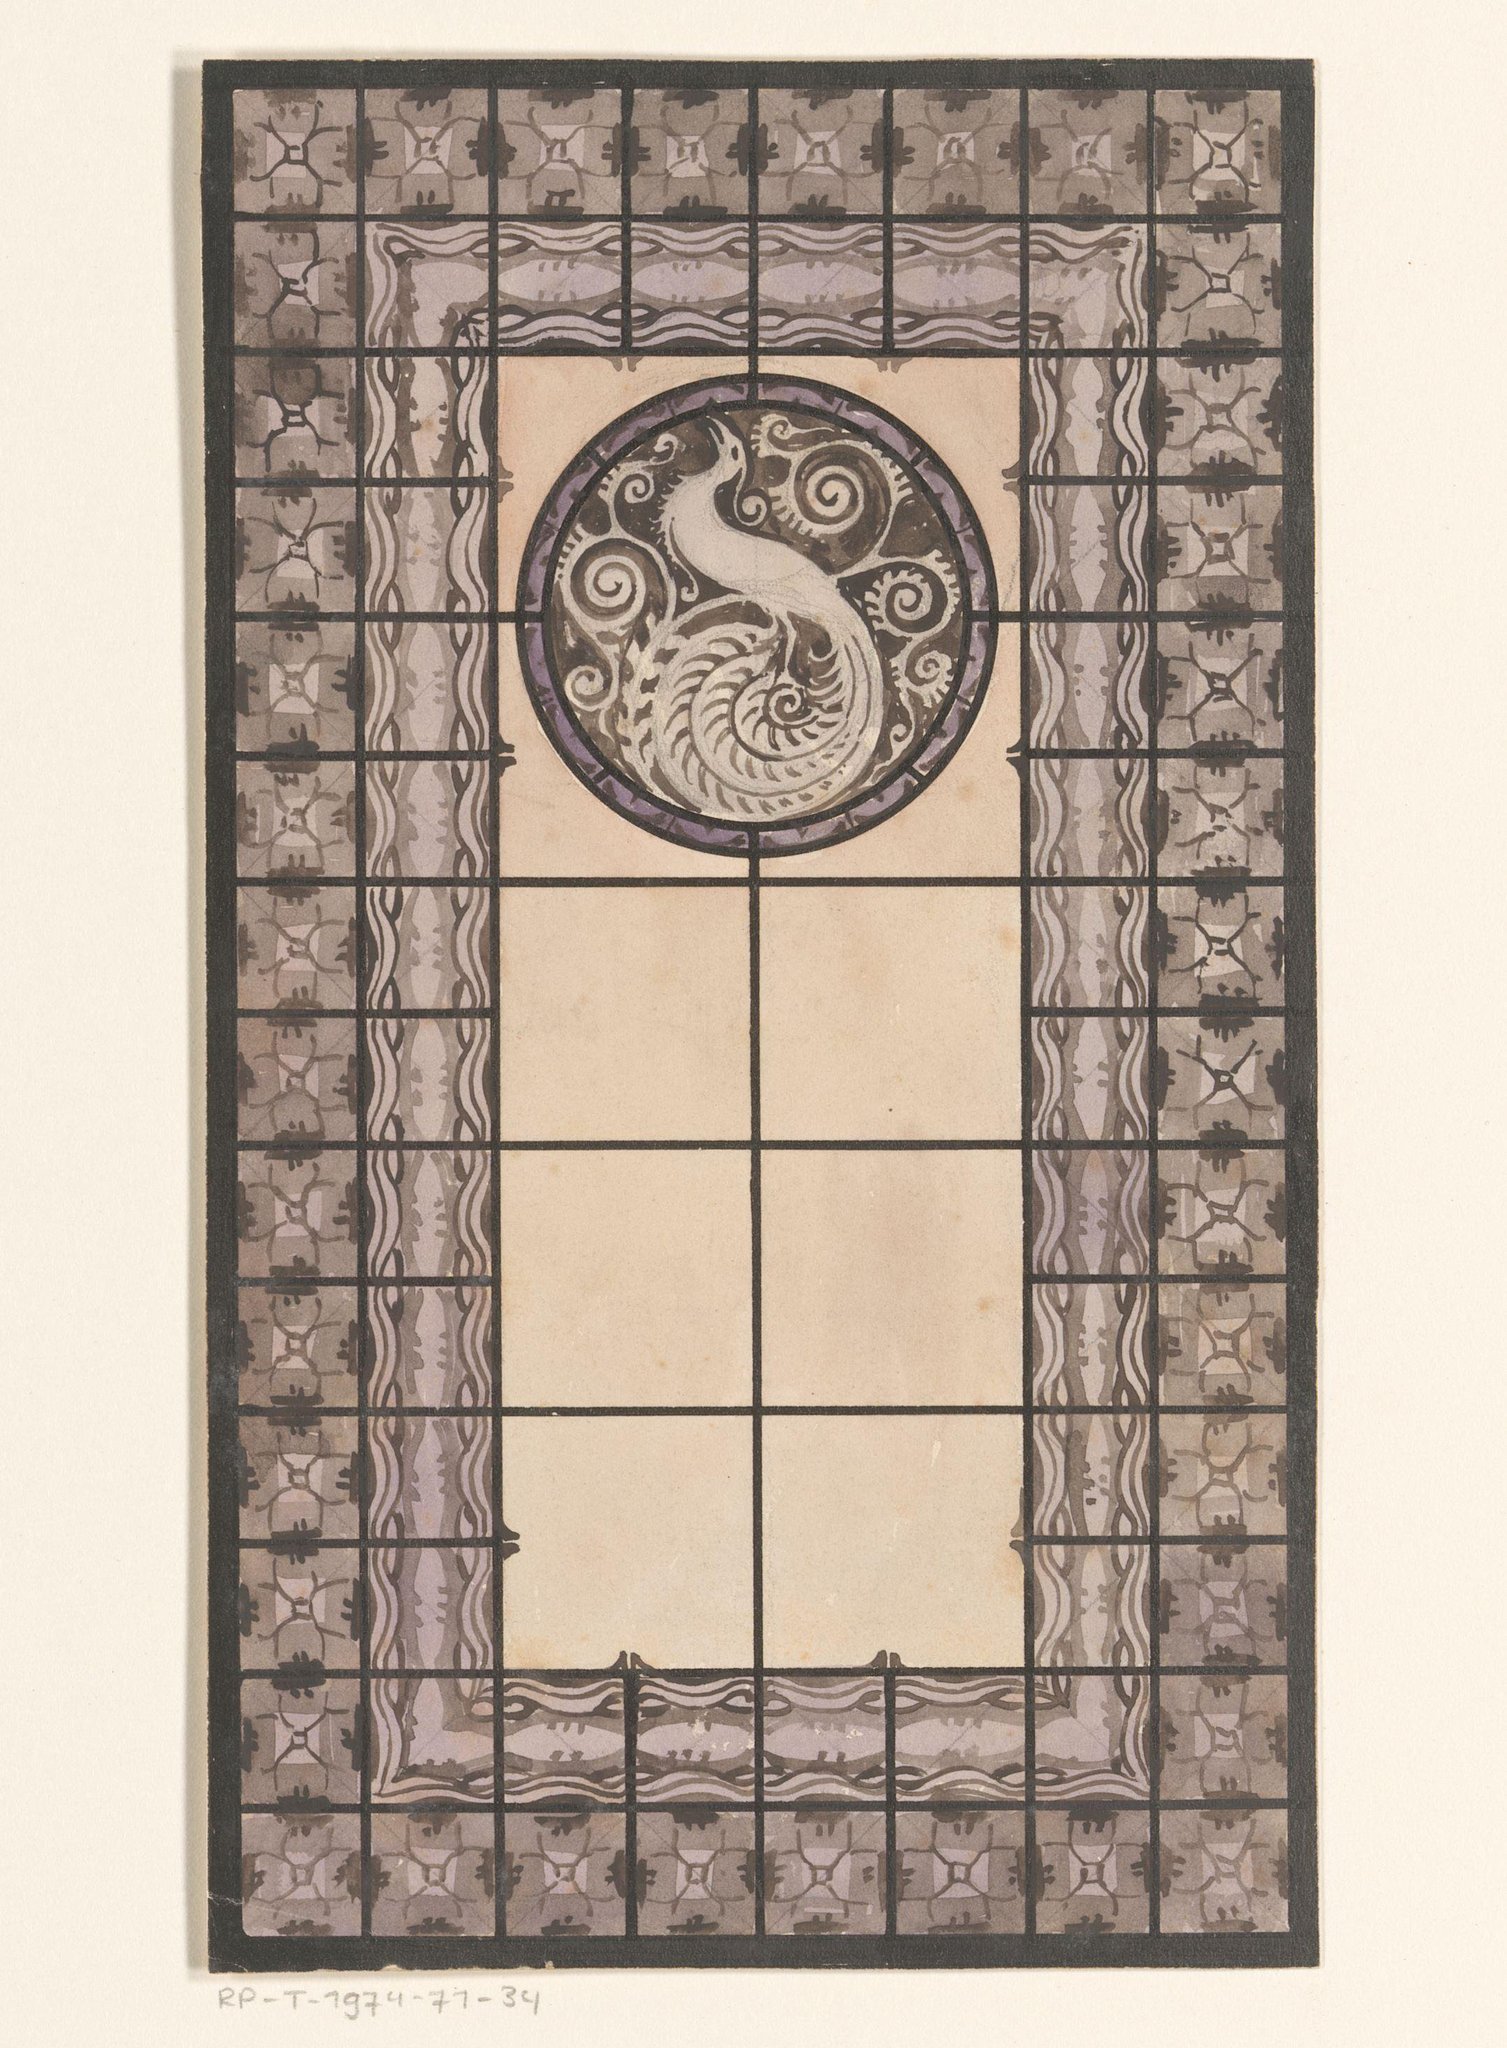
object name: drawing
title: Ontwerp voor een glas in loodraam met een pauw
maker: Anonymous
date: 1907-1930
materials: ink, paper, pencil, watercolor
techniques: brush, pen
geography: amsterdam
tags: ornaments ~ art, ornament derived from animal forms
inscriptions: collector's mark: ‘R:MVS’